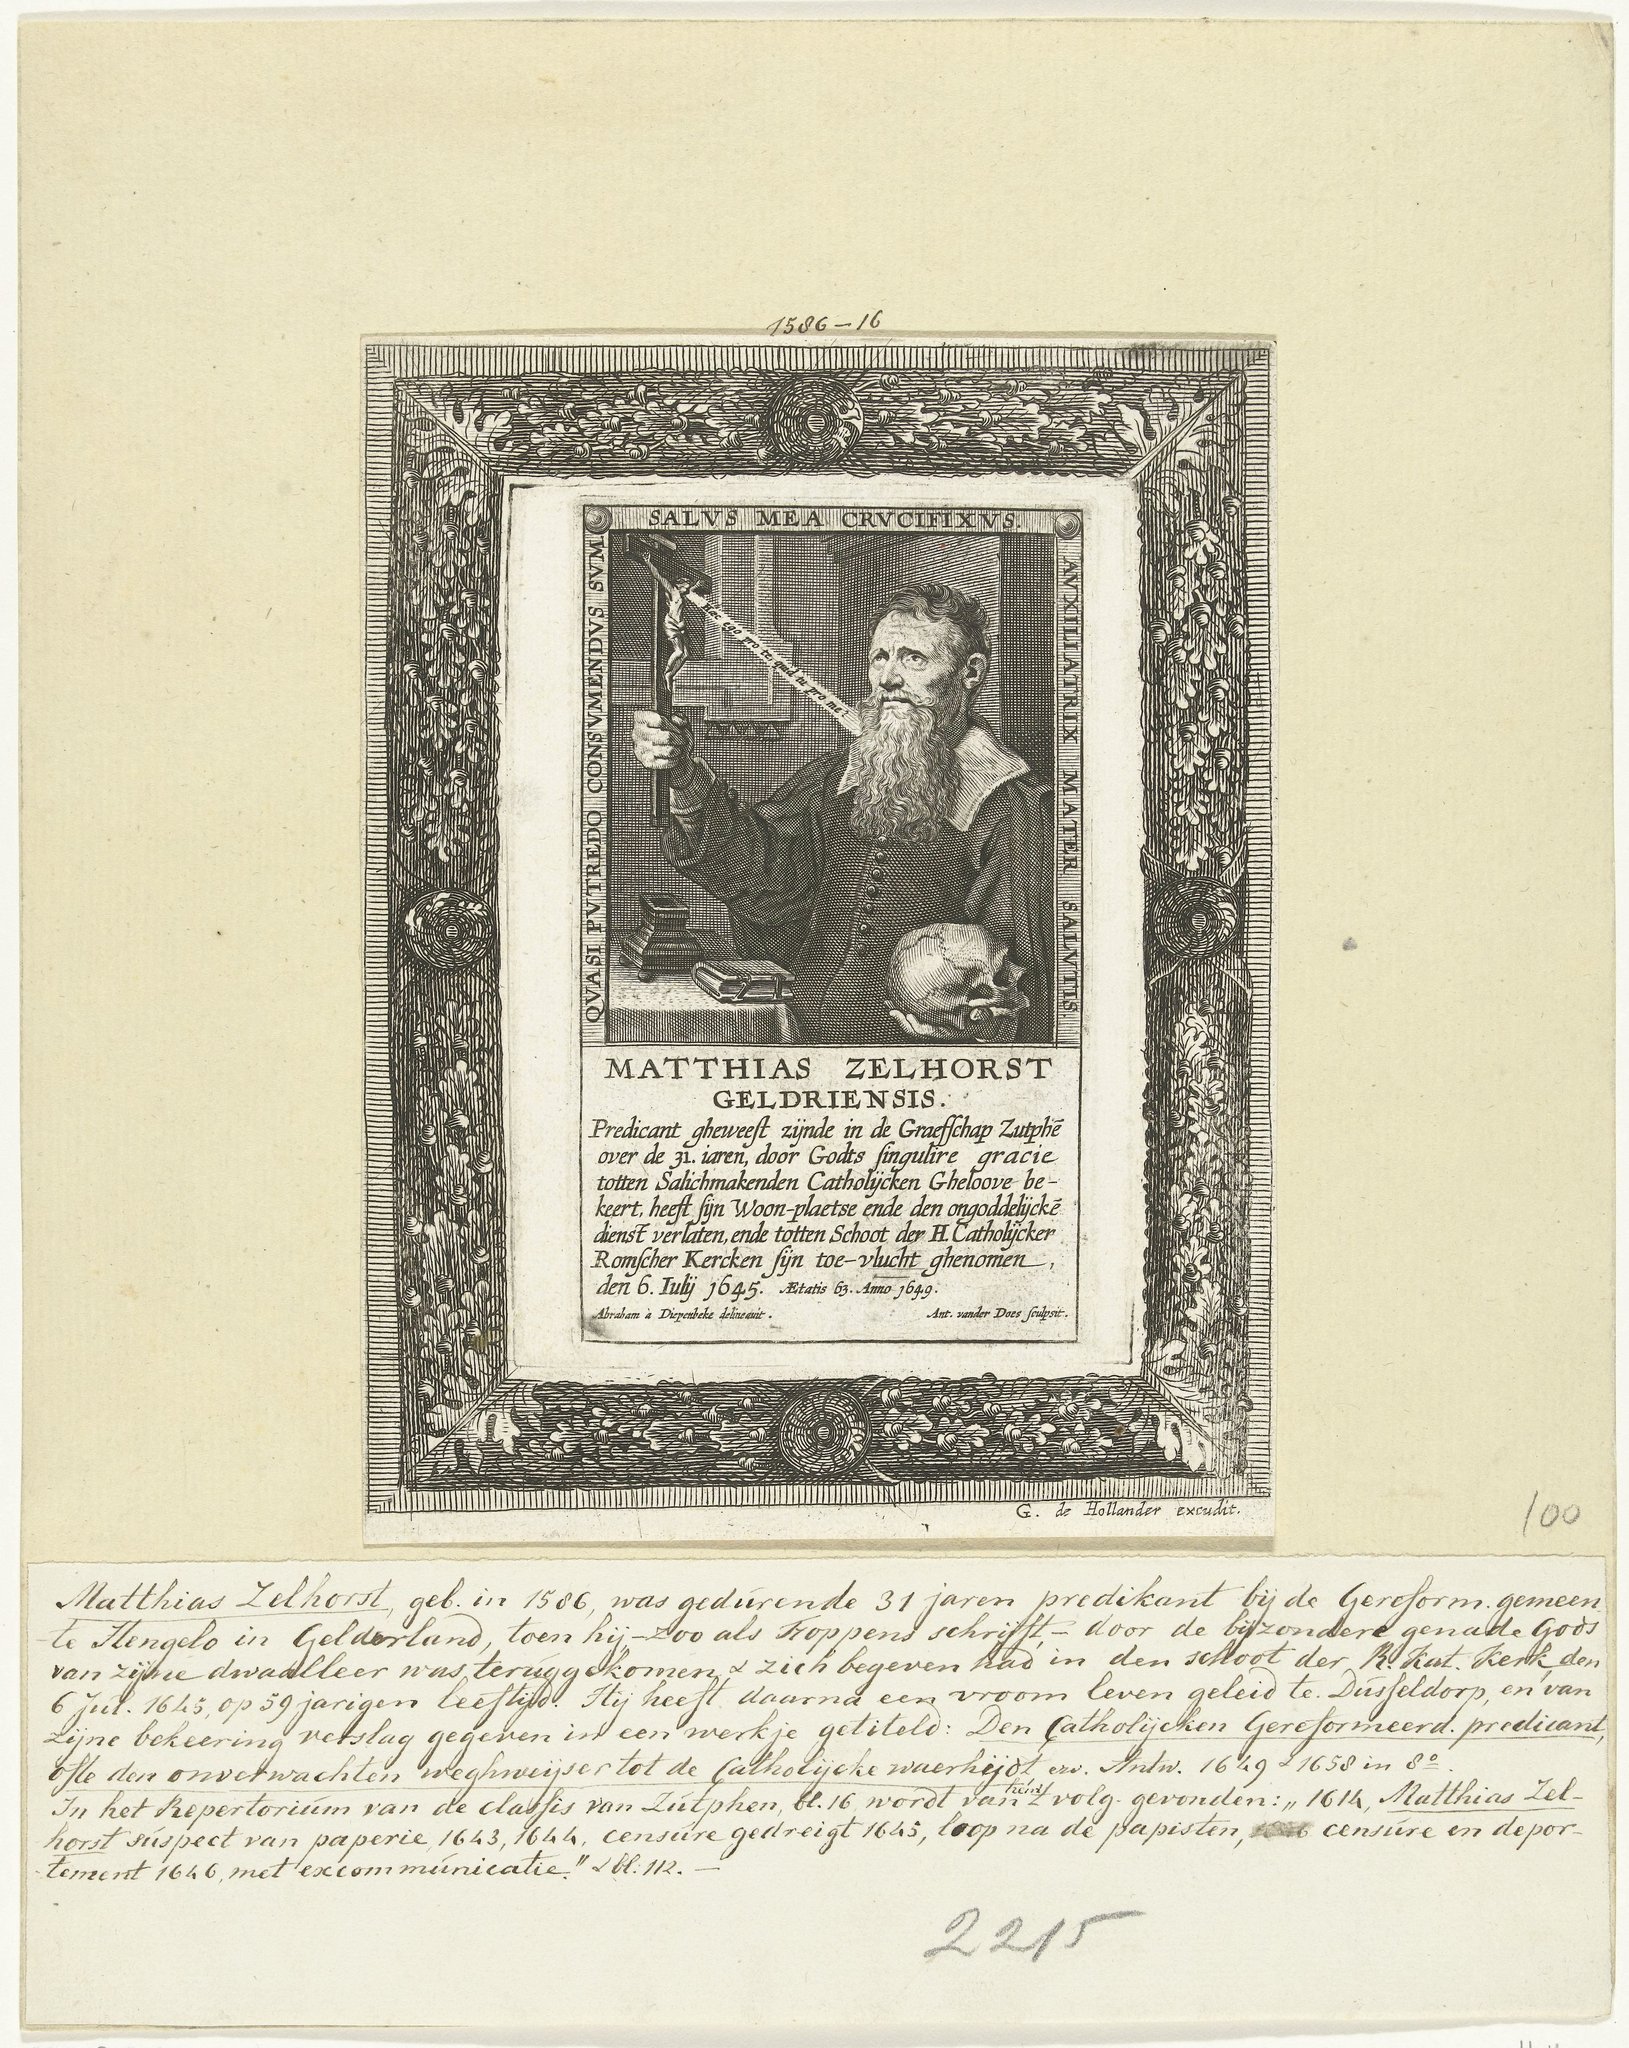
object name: print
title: Portret van Matthias Zelhorst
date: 1645-1649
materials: paper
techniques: engraving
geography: southern netherlands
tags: düsseldorf, predikant, matthias zelhorst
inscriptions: collector's mark: Lugt 2228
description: Portret van Matthias Zelhorst, halffiguur zittend met schedel en crucifix. Onder portret negen regels Nederlandse tekst. In rechthoekige omlijsting gedecoreerd met eikenbladeren, gedrukt met een aparte plaat.